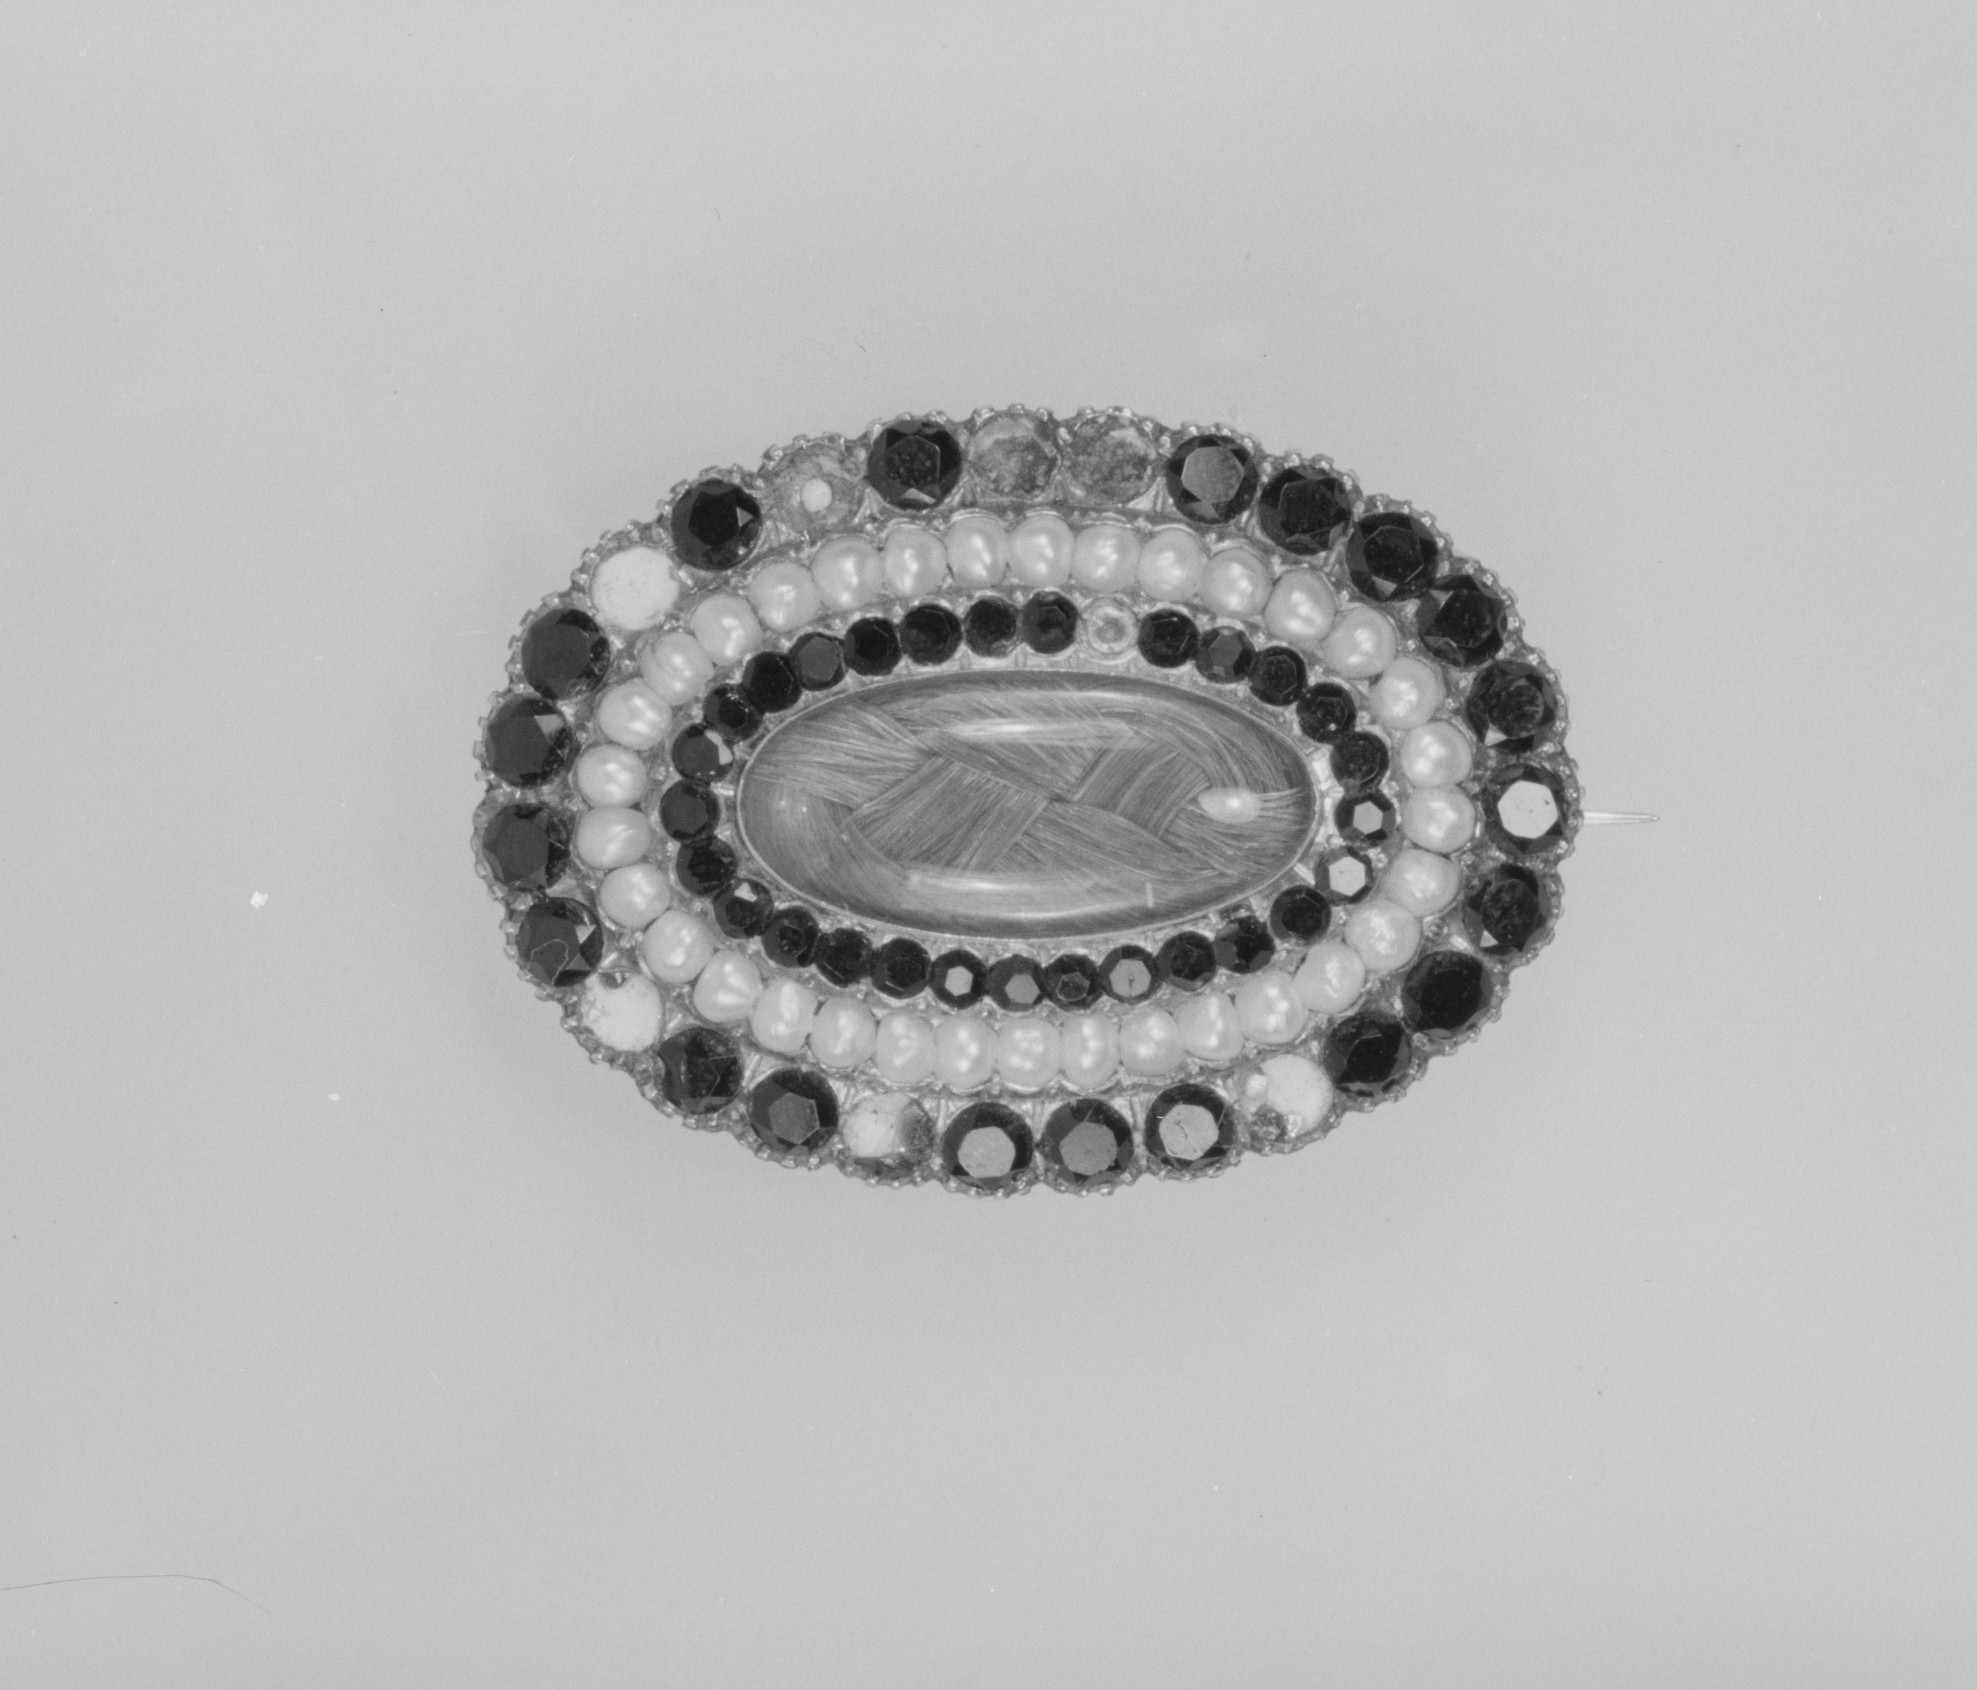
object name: brooch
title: Mourning Pin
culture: american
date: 1862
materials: gold, pearl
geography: united states